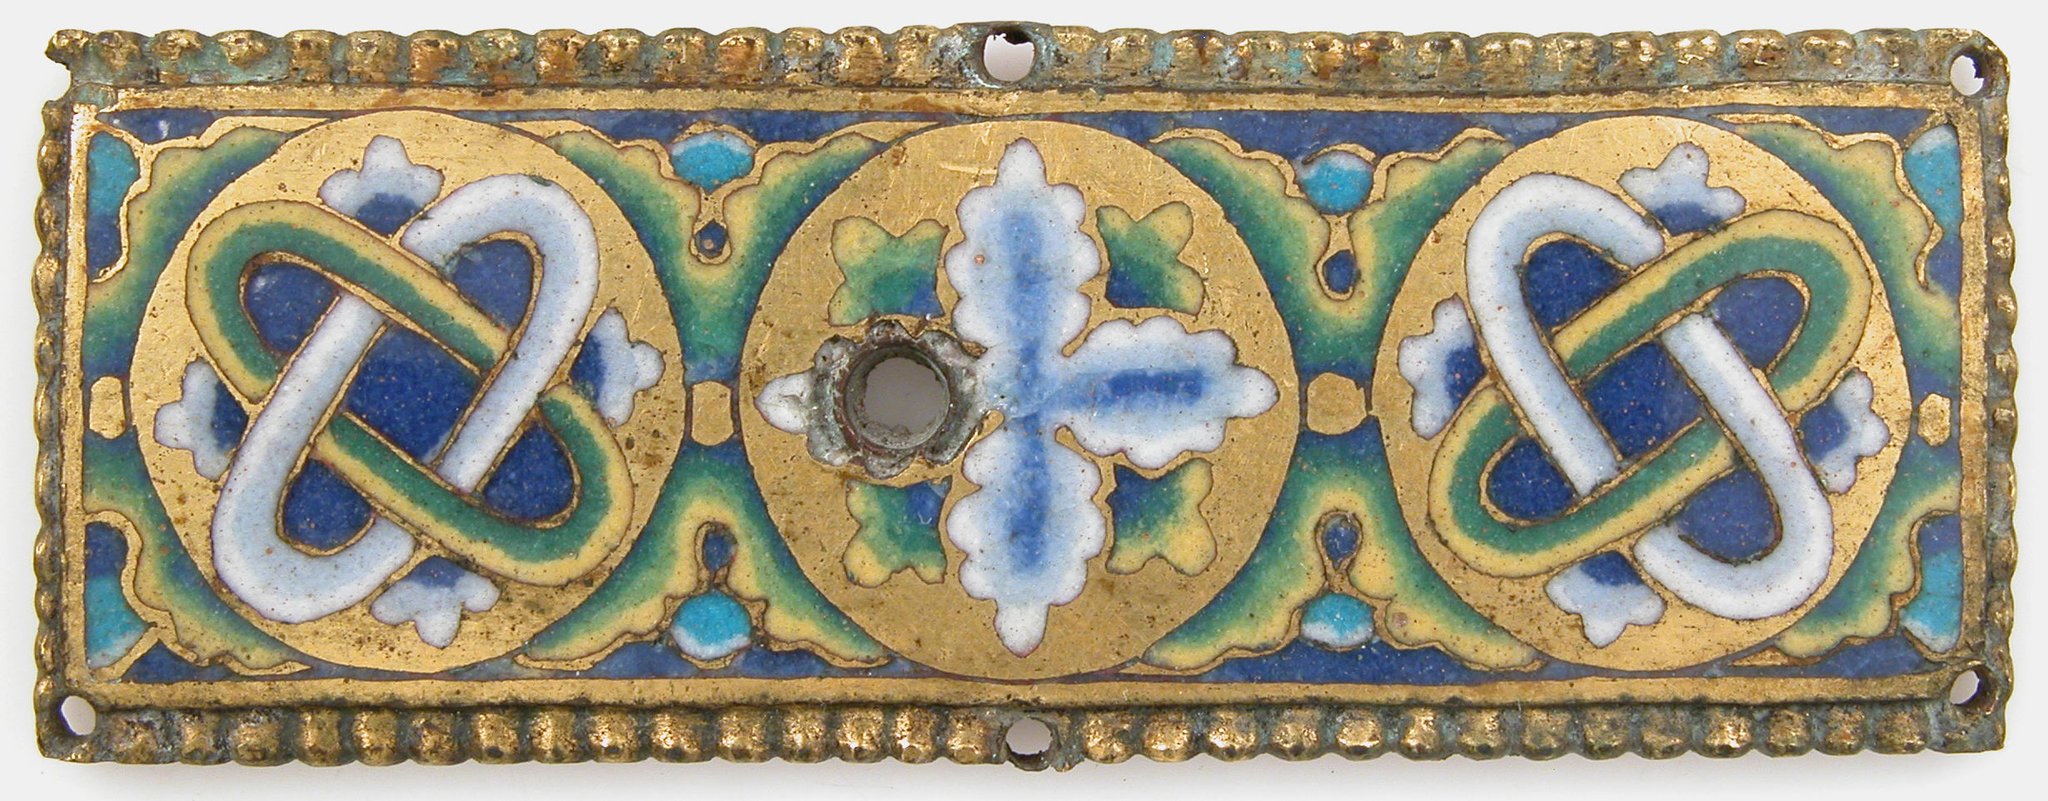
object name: plaque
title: Plaque from a Reliquary Shrine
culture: german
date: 1180-1190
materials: copper alloy, enamel, gilt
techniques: enamel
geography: germany